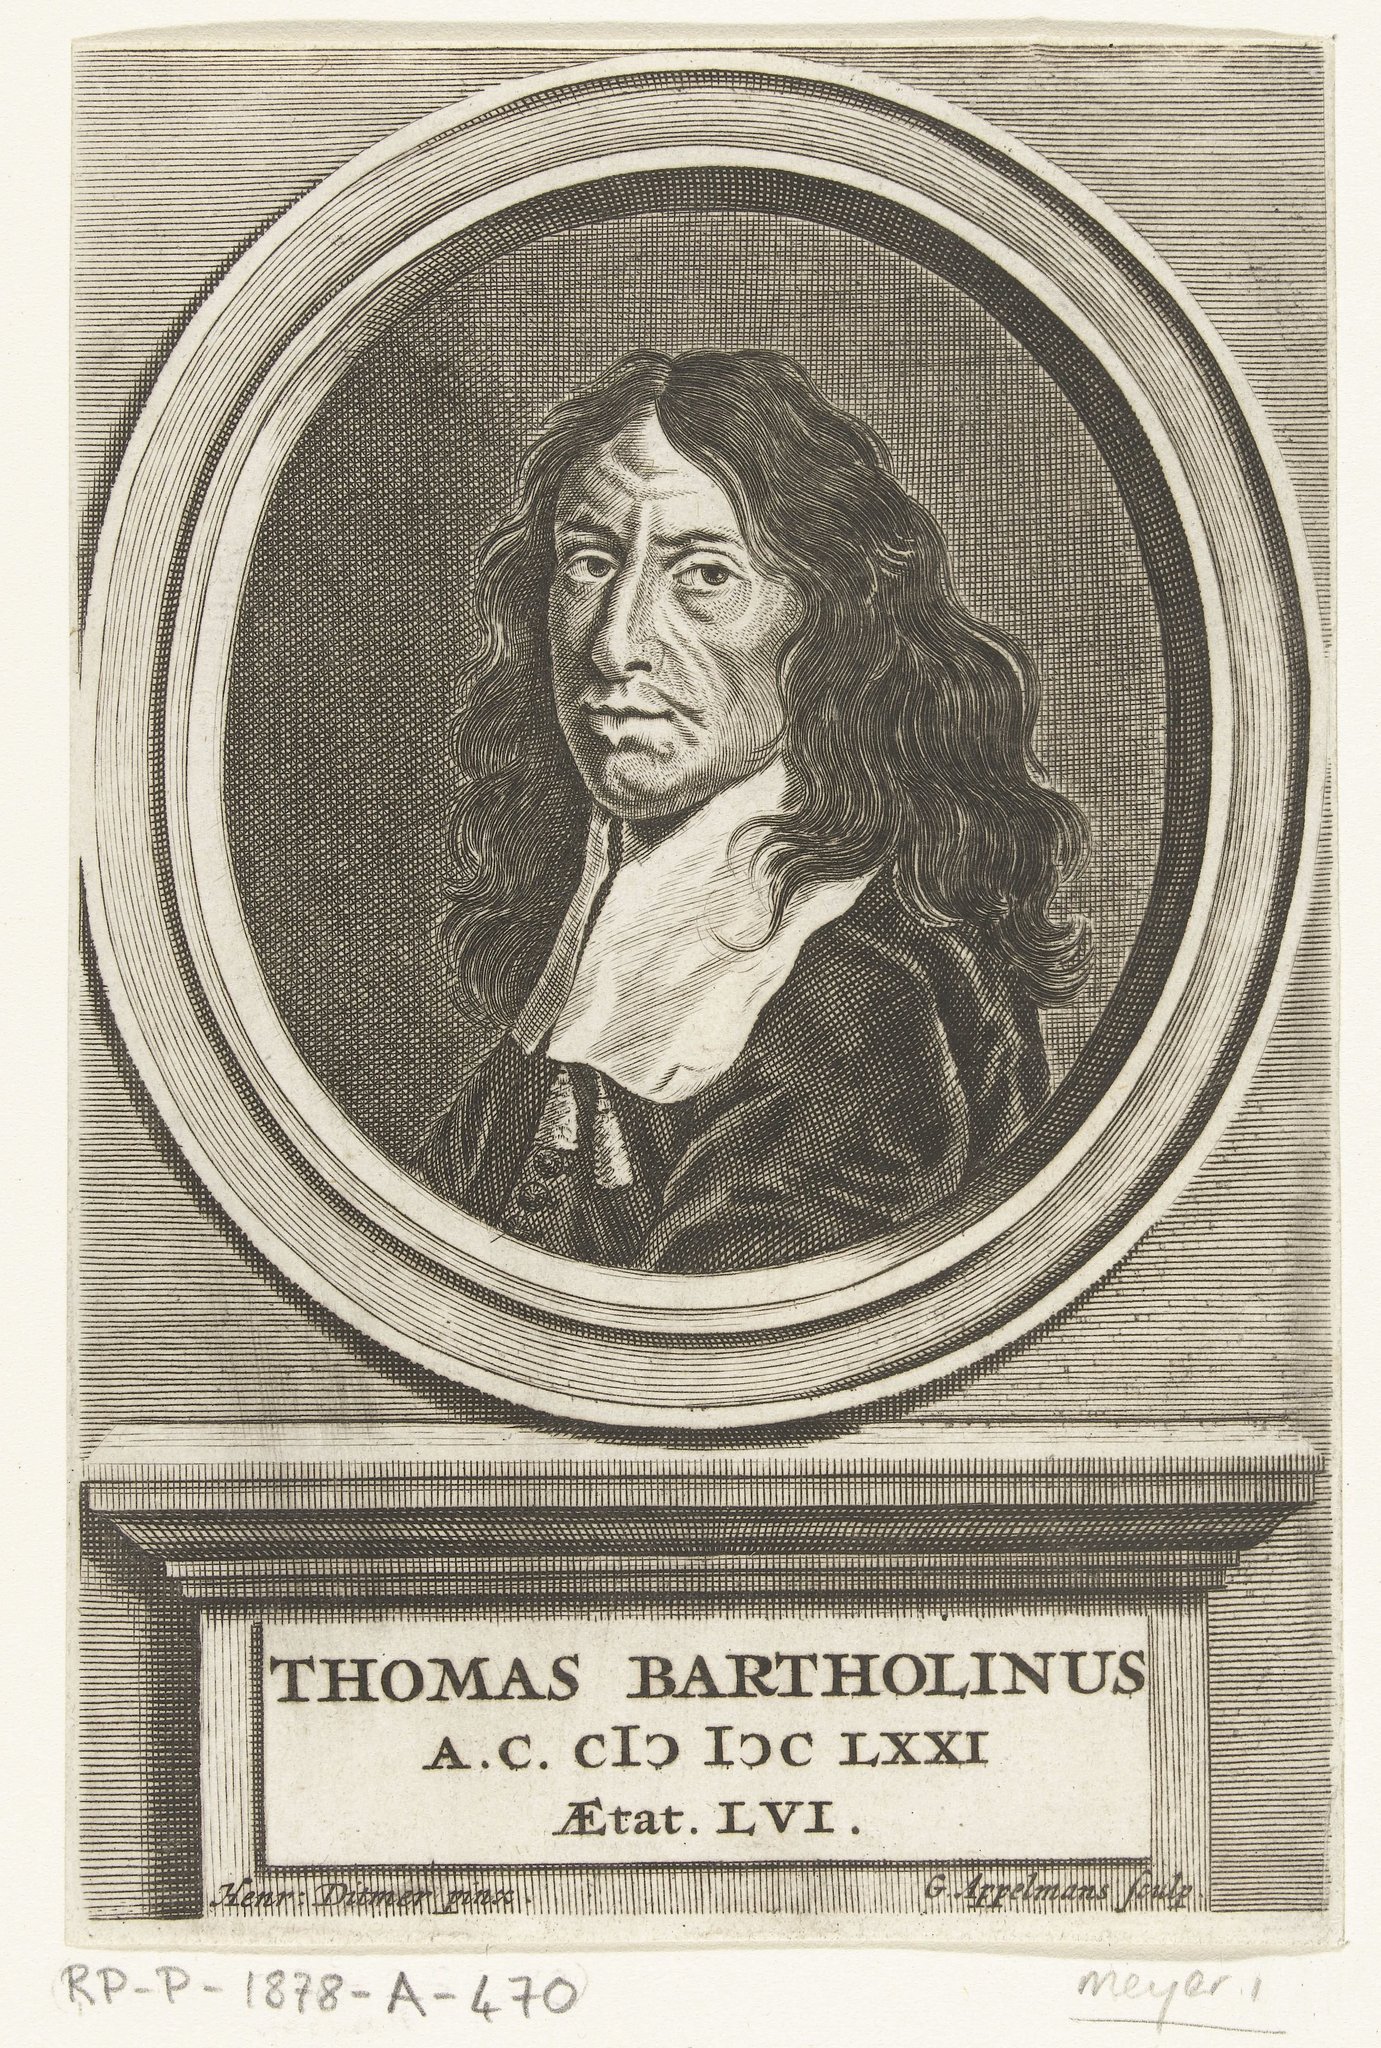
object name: print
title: Portret van Thomas Bartholinus op 61 jarige leeftijd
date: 1670-1680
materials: paper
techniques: engraving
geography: netherlands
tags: copenhagen (city), thomas bartholin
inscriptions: collector's mark: Lugt 2228